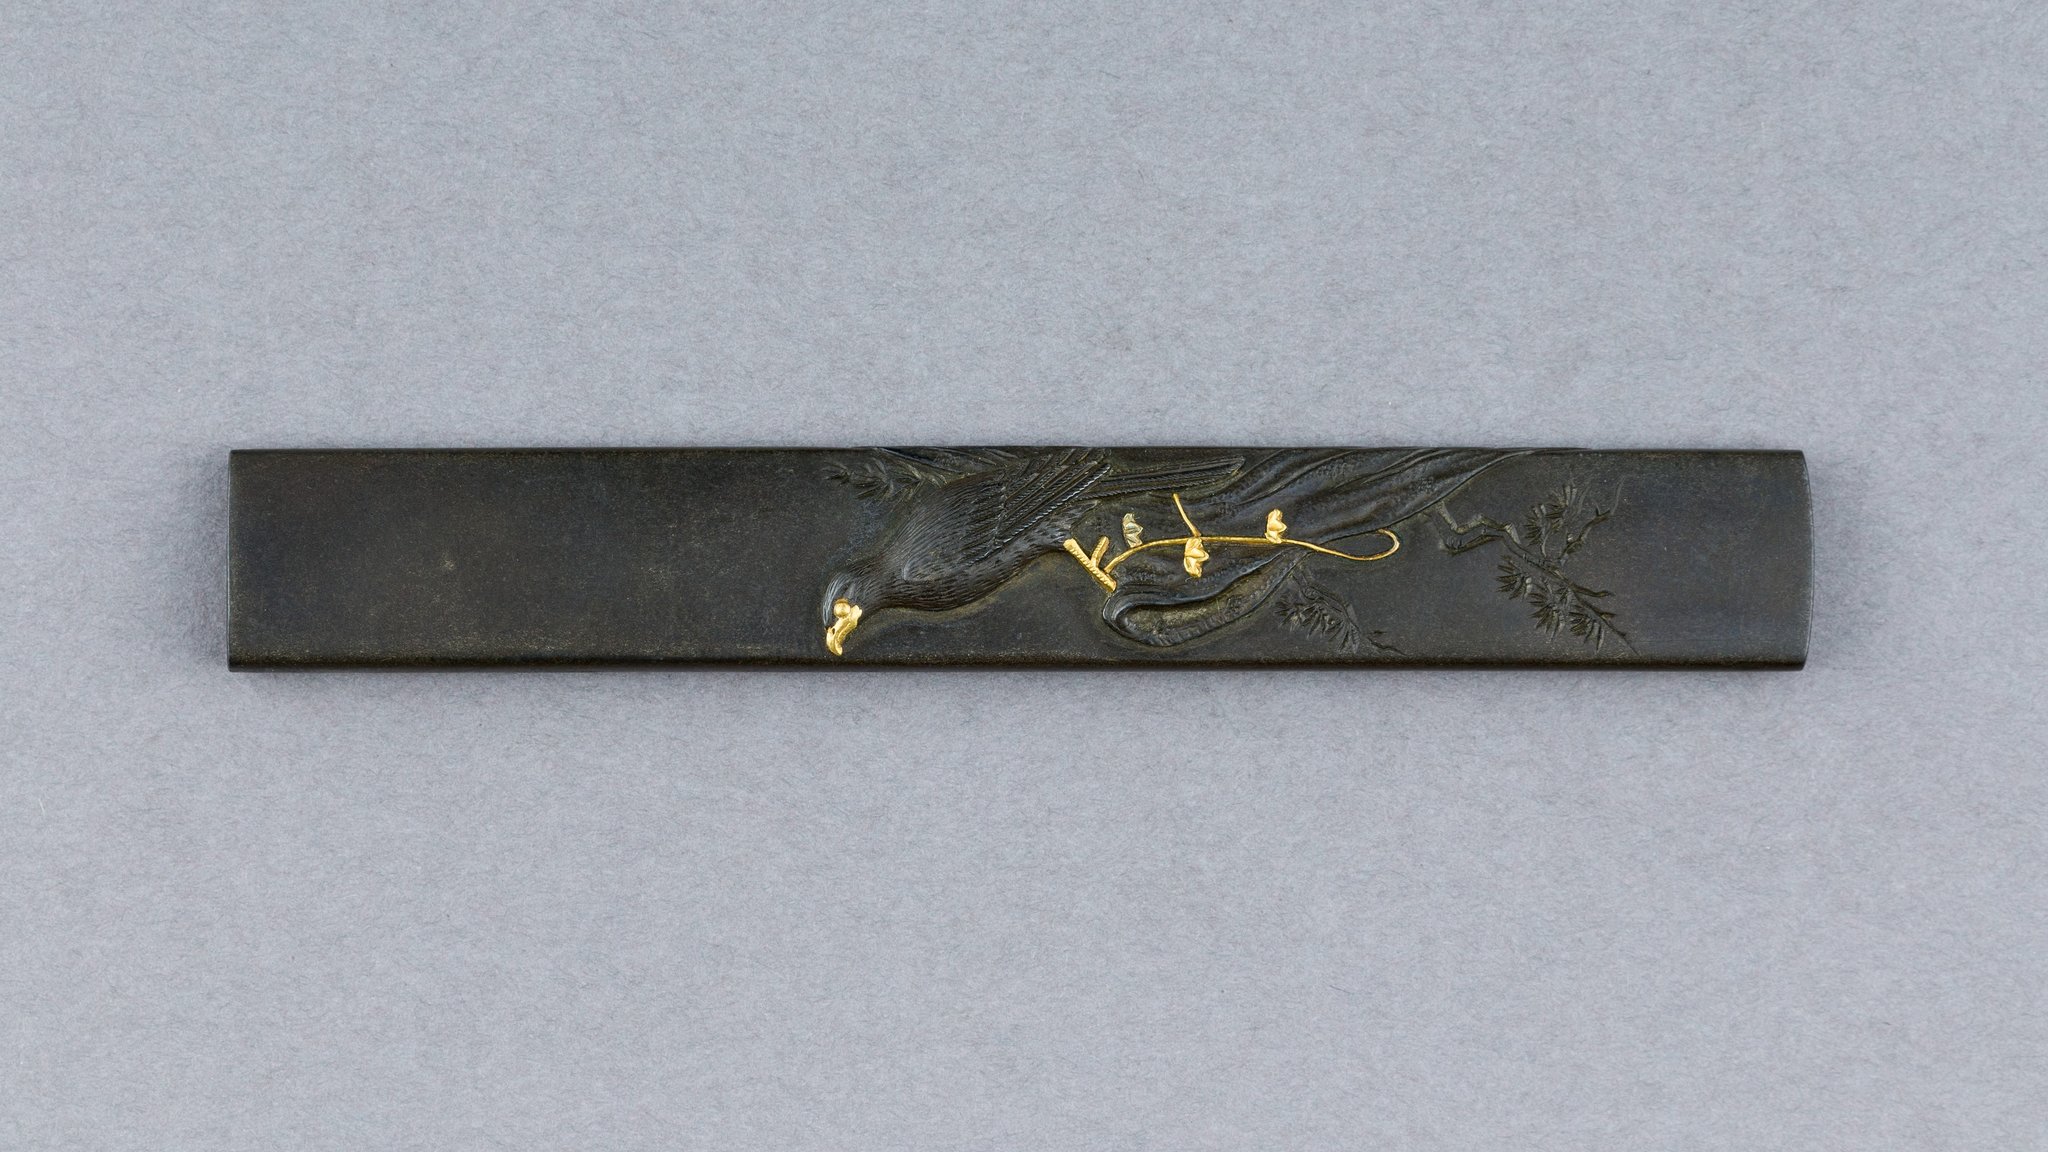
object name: knife handle kozuka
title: Knife Handle (Kozuka)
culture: japanese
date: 1615-1868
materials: silver alloy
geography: japan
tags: birds